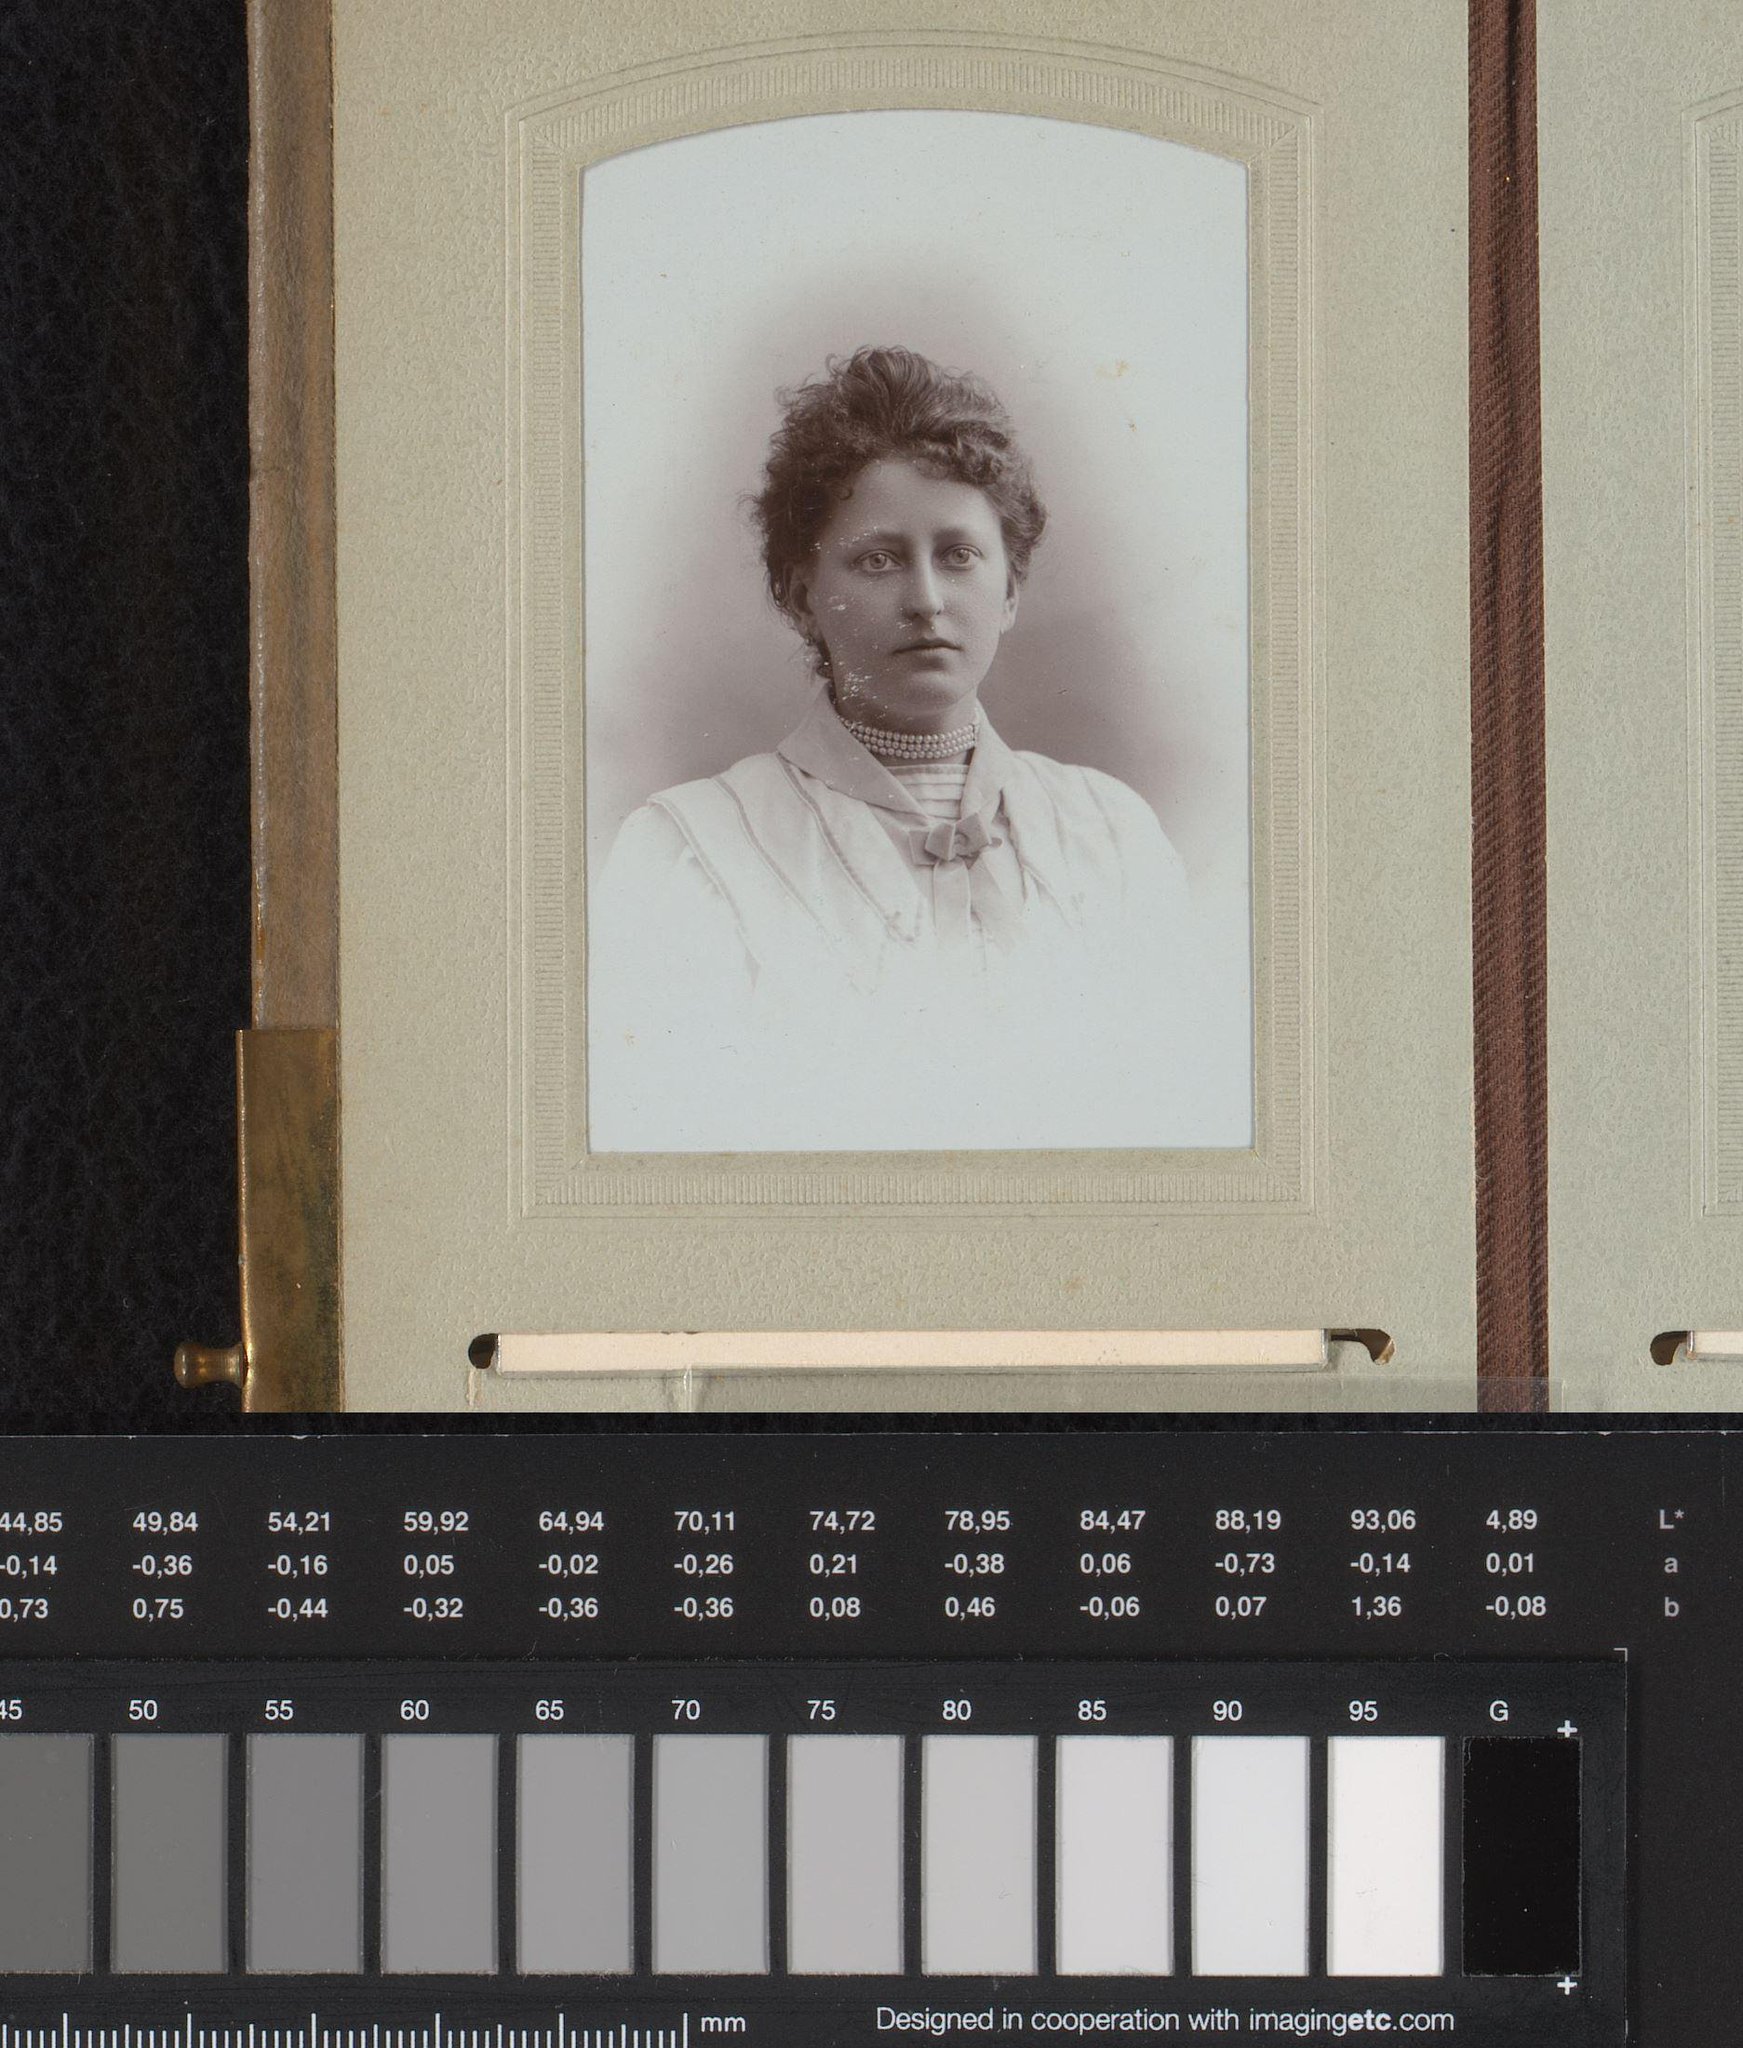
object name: photograph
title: Portret van een vrouw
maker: machiel hendricus laddé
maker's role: fotograaf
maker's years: 1866-1932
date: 1890-1910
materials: cardboard, photographic support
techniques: collodion silver print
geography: amsterdam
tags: adult woman, historical persons